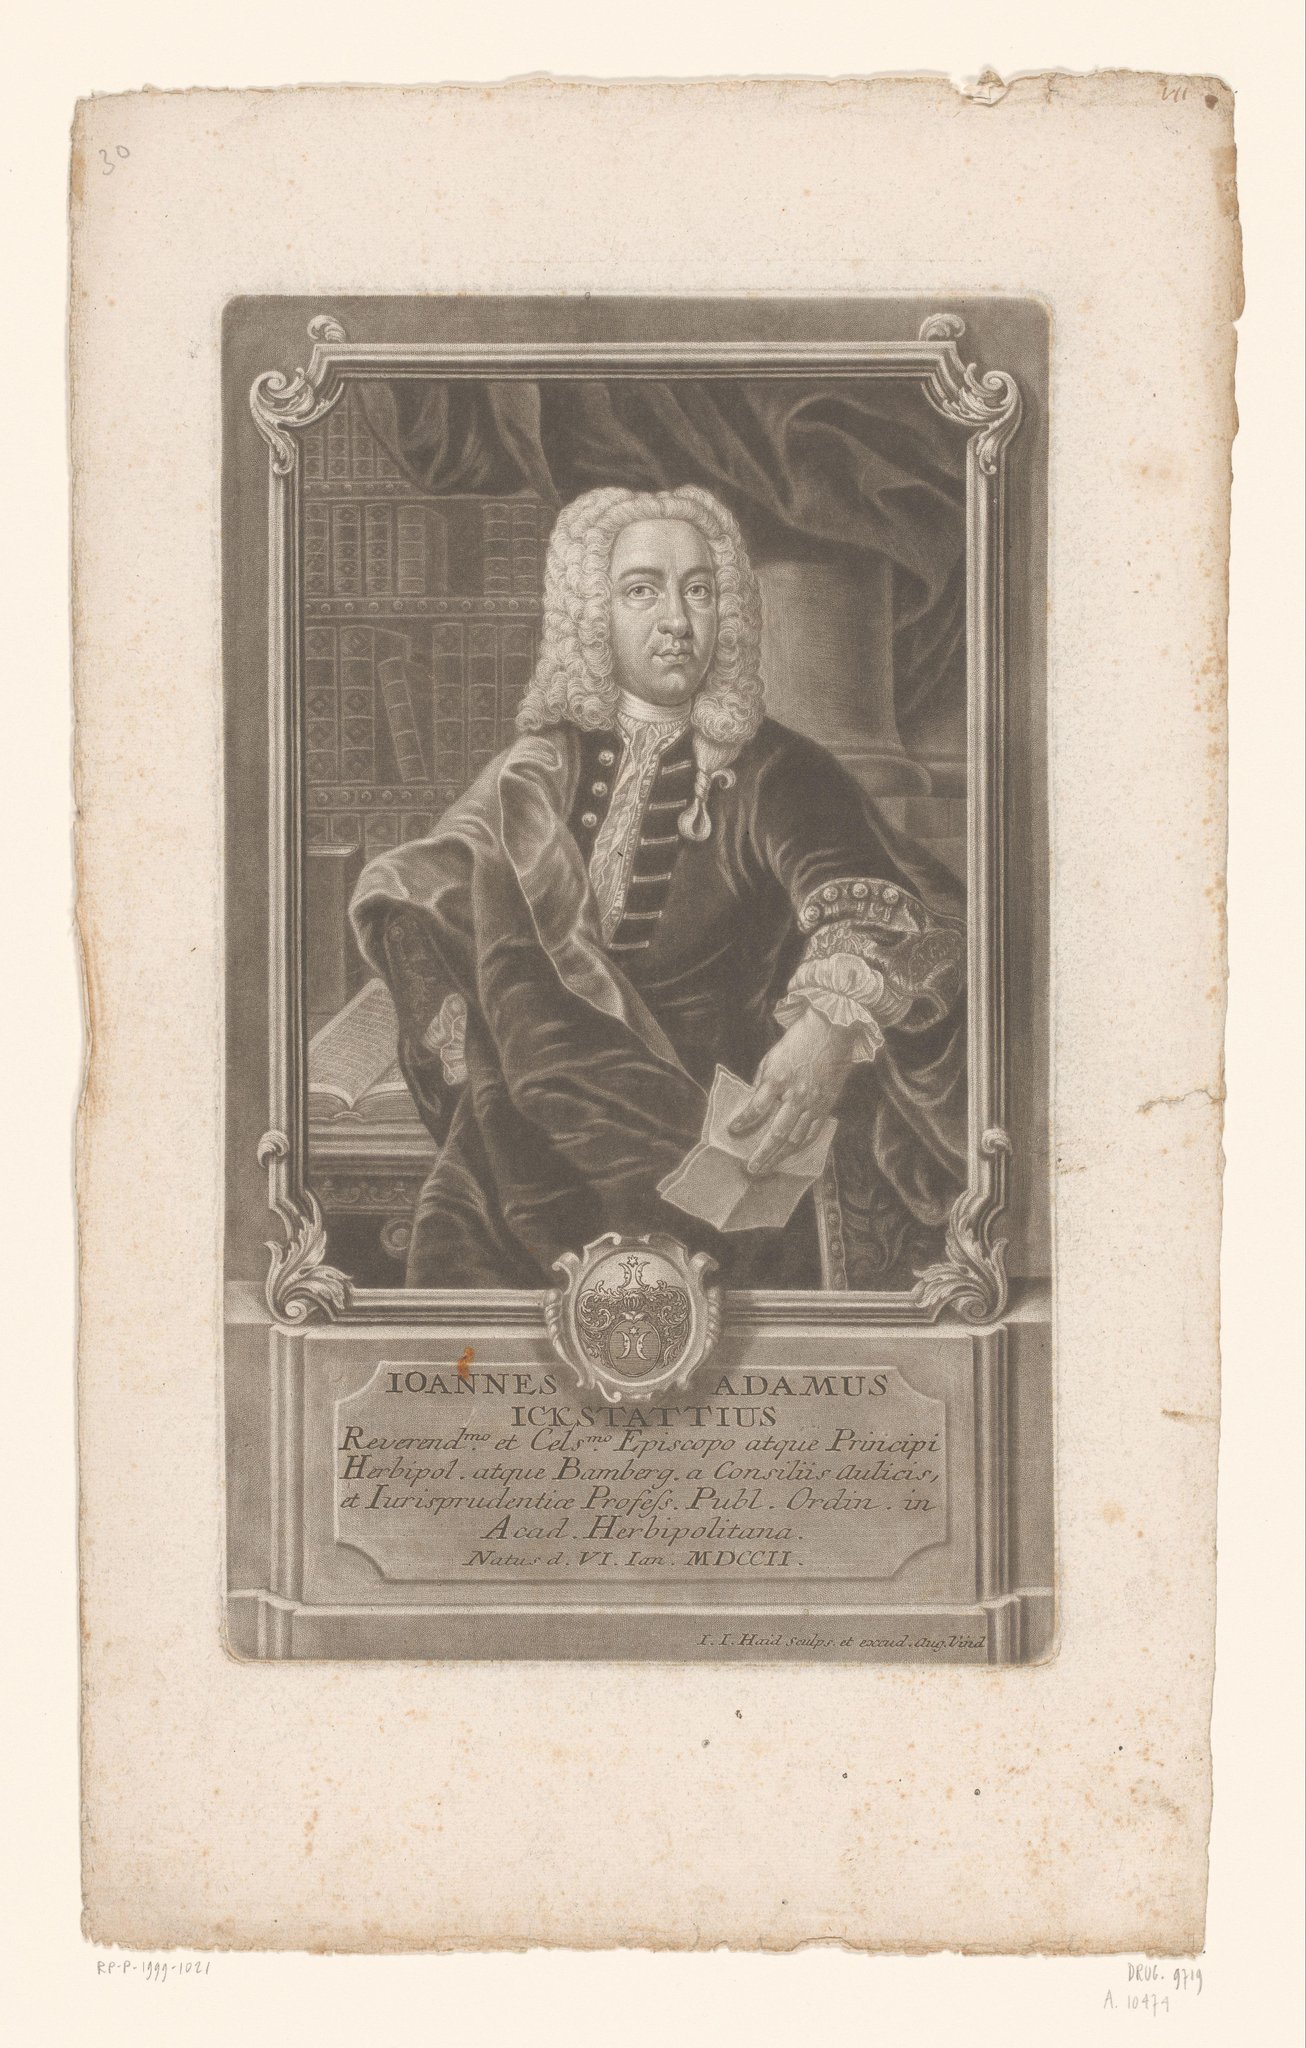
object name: print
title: Portret van Johann Adam von Ickstatt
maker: johann jacob haid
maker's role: print maker, publisher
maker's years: 1704-1767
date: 1741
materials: paper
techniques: etching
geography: augsburg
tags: bookshelves, historical persons, armorial bearing, heraldry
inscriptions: collector's mark: Lugt 2760, collector's mark: Lugt 2228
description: Prent gebruikt voor: Brucker, Jacob. Bildersal heutiges Tages lebender und durch Gelahrheit berühmter Schrifftsteller. Augsburg: Johann Jacob Haid, 1741.